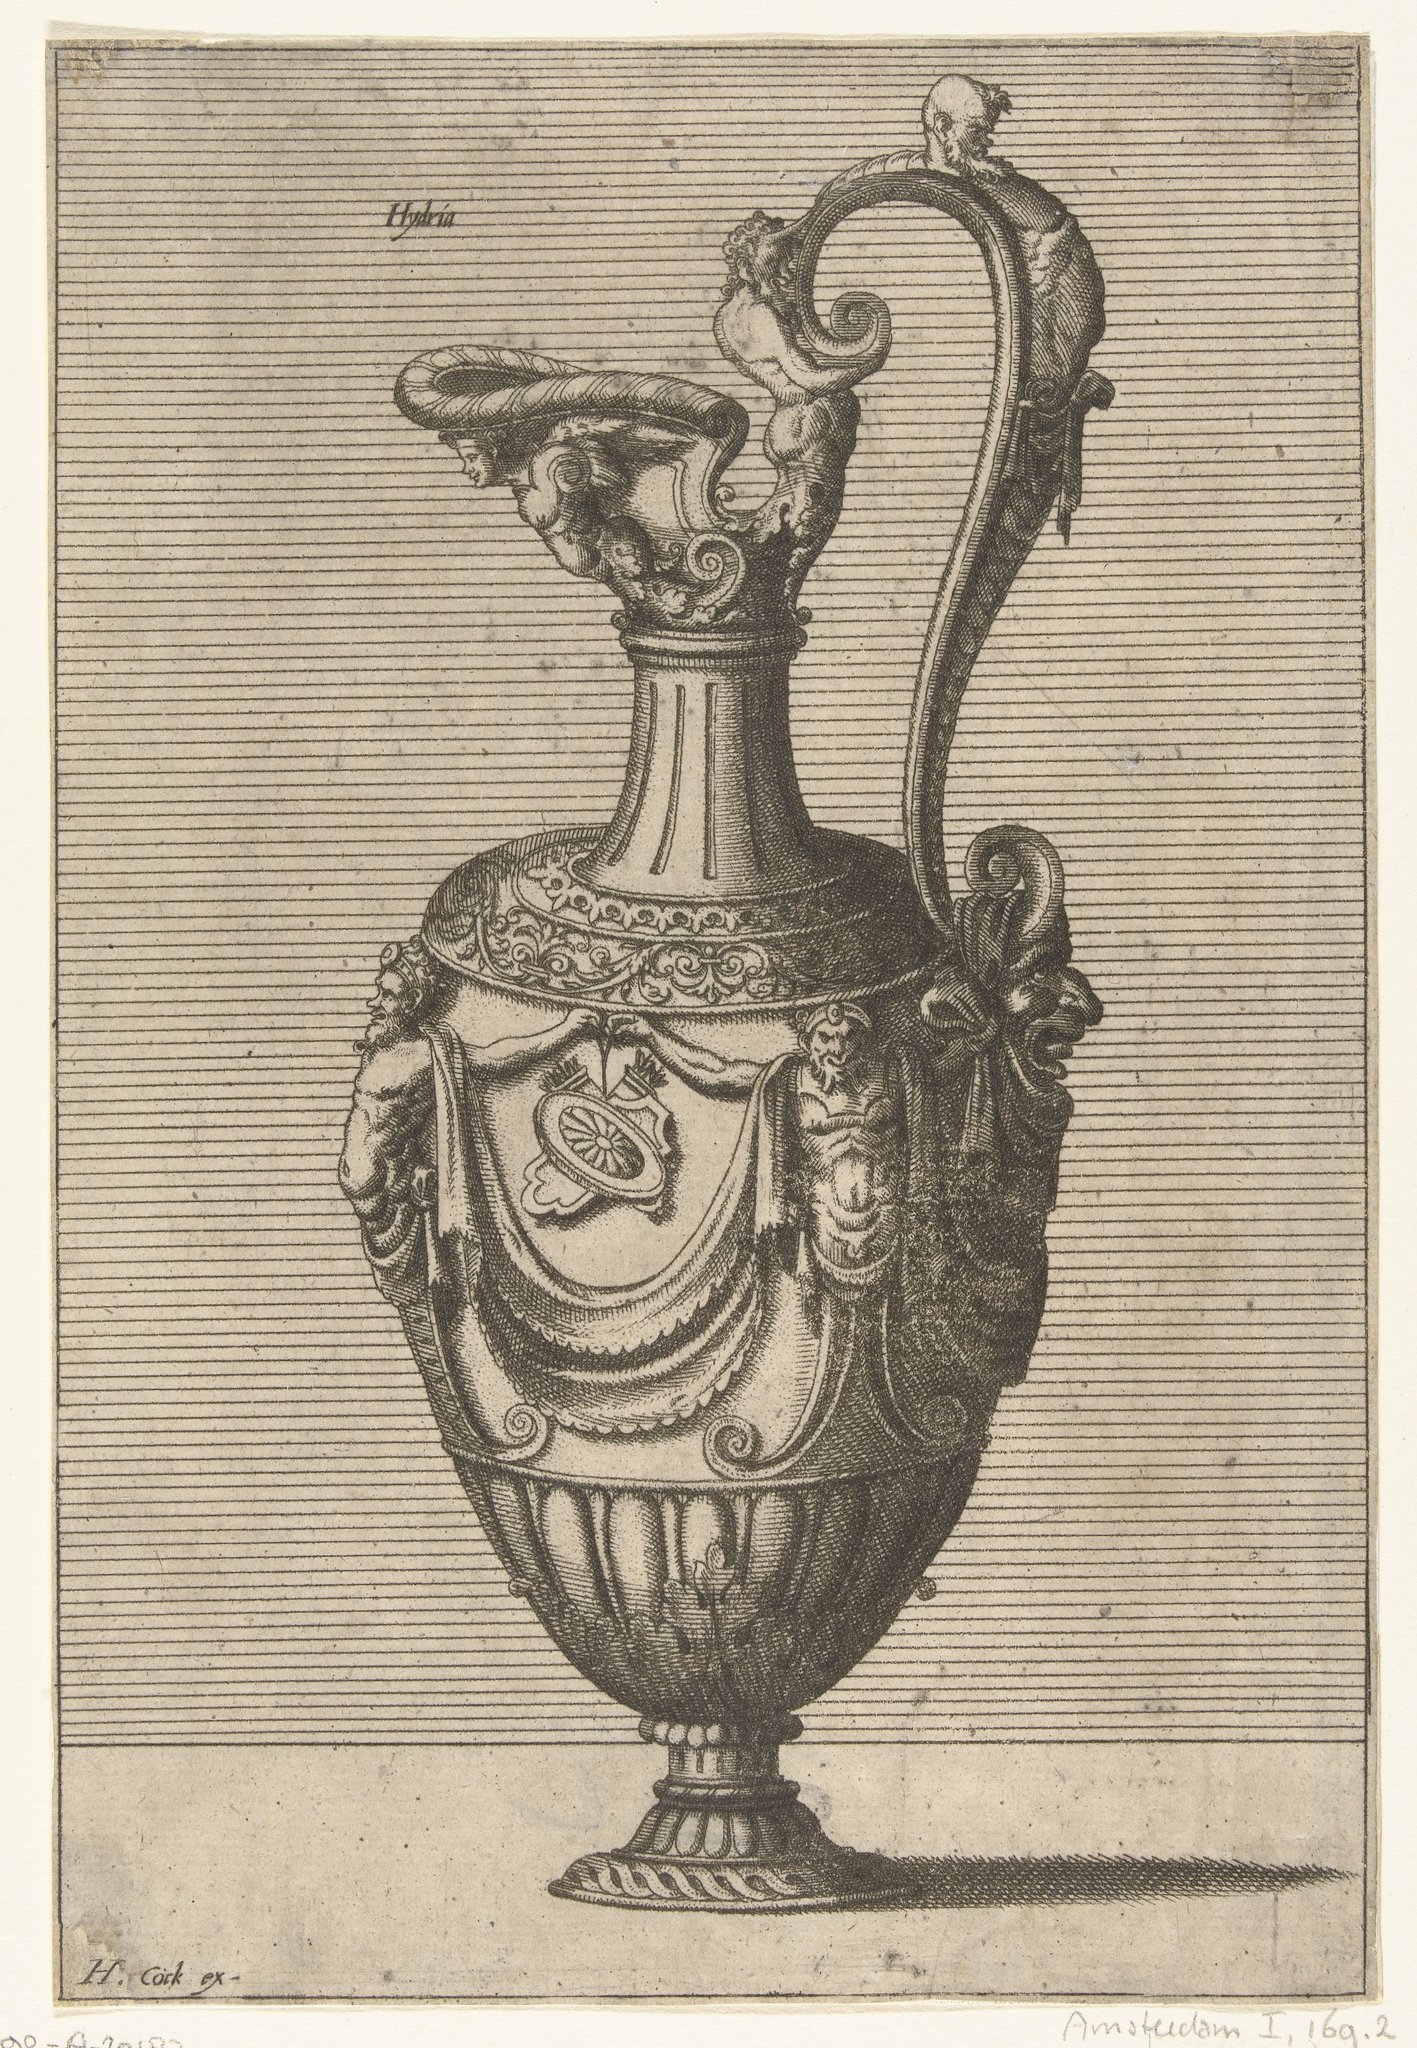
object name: print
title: Hydria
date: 1563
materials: paper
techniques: etching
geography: netherlands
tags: jar, jug (used as drinking-vessel)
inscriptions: address: ‘H. Cock ex.’, title: ‘Hydria’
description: Schenkkan naar links. Op de buik van de kan zijn twee hermen zichtbaar, die samen een wapentrofee vasthouden. Tussen hen in plooit zich een over hun schouder hangende draperie. Horizontaal gearceerde achtergrond. Komt uit serie van 12 bladen.